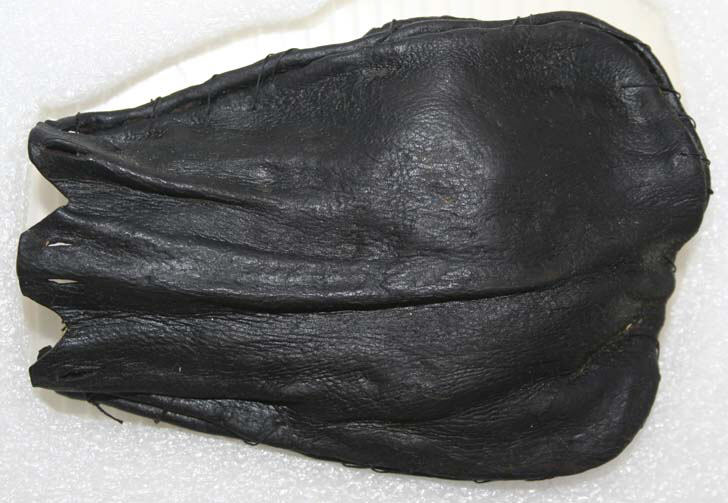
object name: purse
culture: british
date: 1501-1600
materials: leather